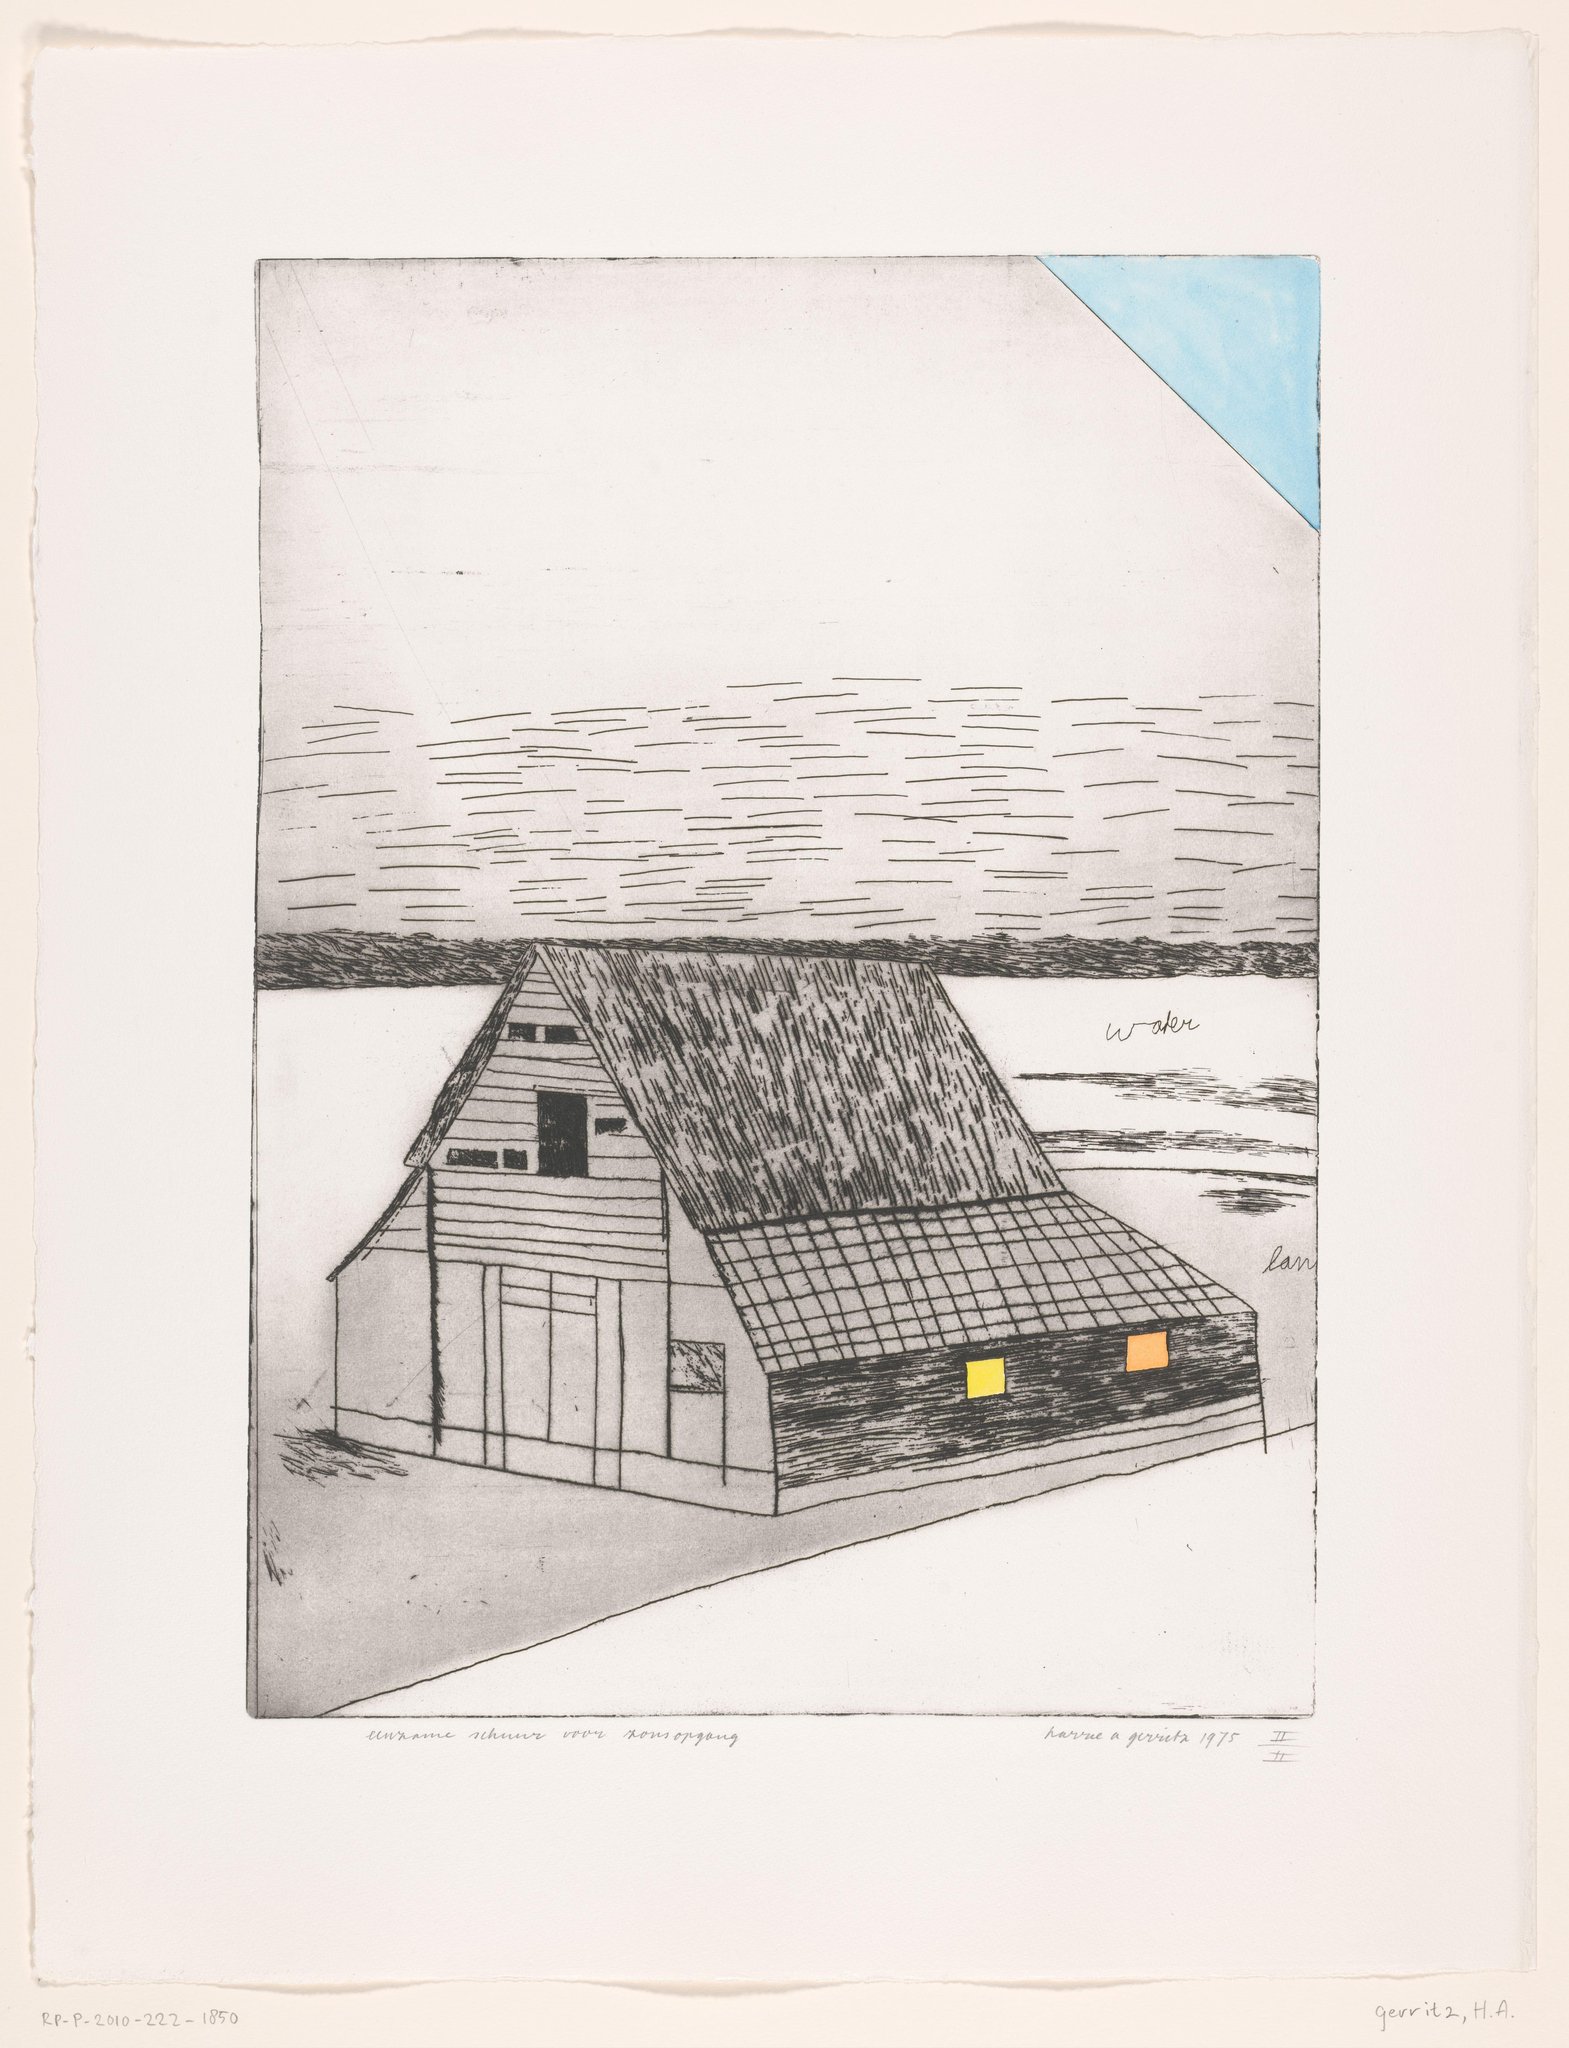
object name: print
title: Eenzame schuur voor zonsopgang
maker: harrie a. gerritz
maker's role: draughtsman, painter, print maker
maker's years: 1940-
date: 1975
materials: paper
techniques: etching, hand coloring, intaglio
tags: rural housing, e.g. country-house, villa, cottage, water course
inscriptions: inscription: ‘PC’, collector's mark: Lugt 2228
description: Schuur aan het water met een oranje en een geel raam.